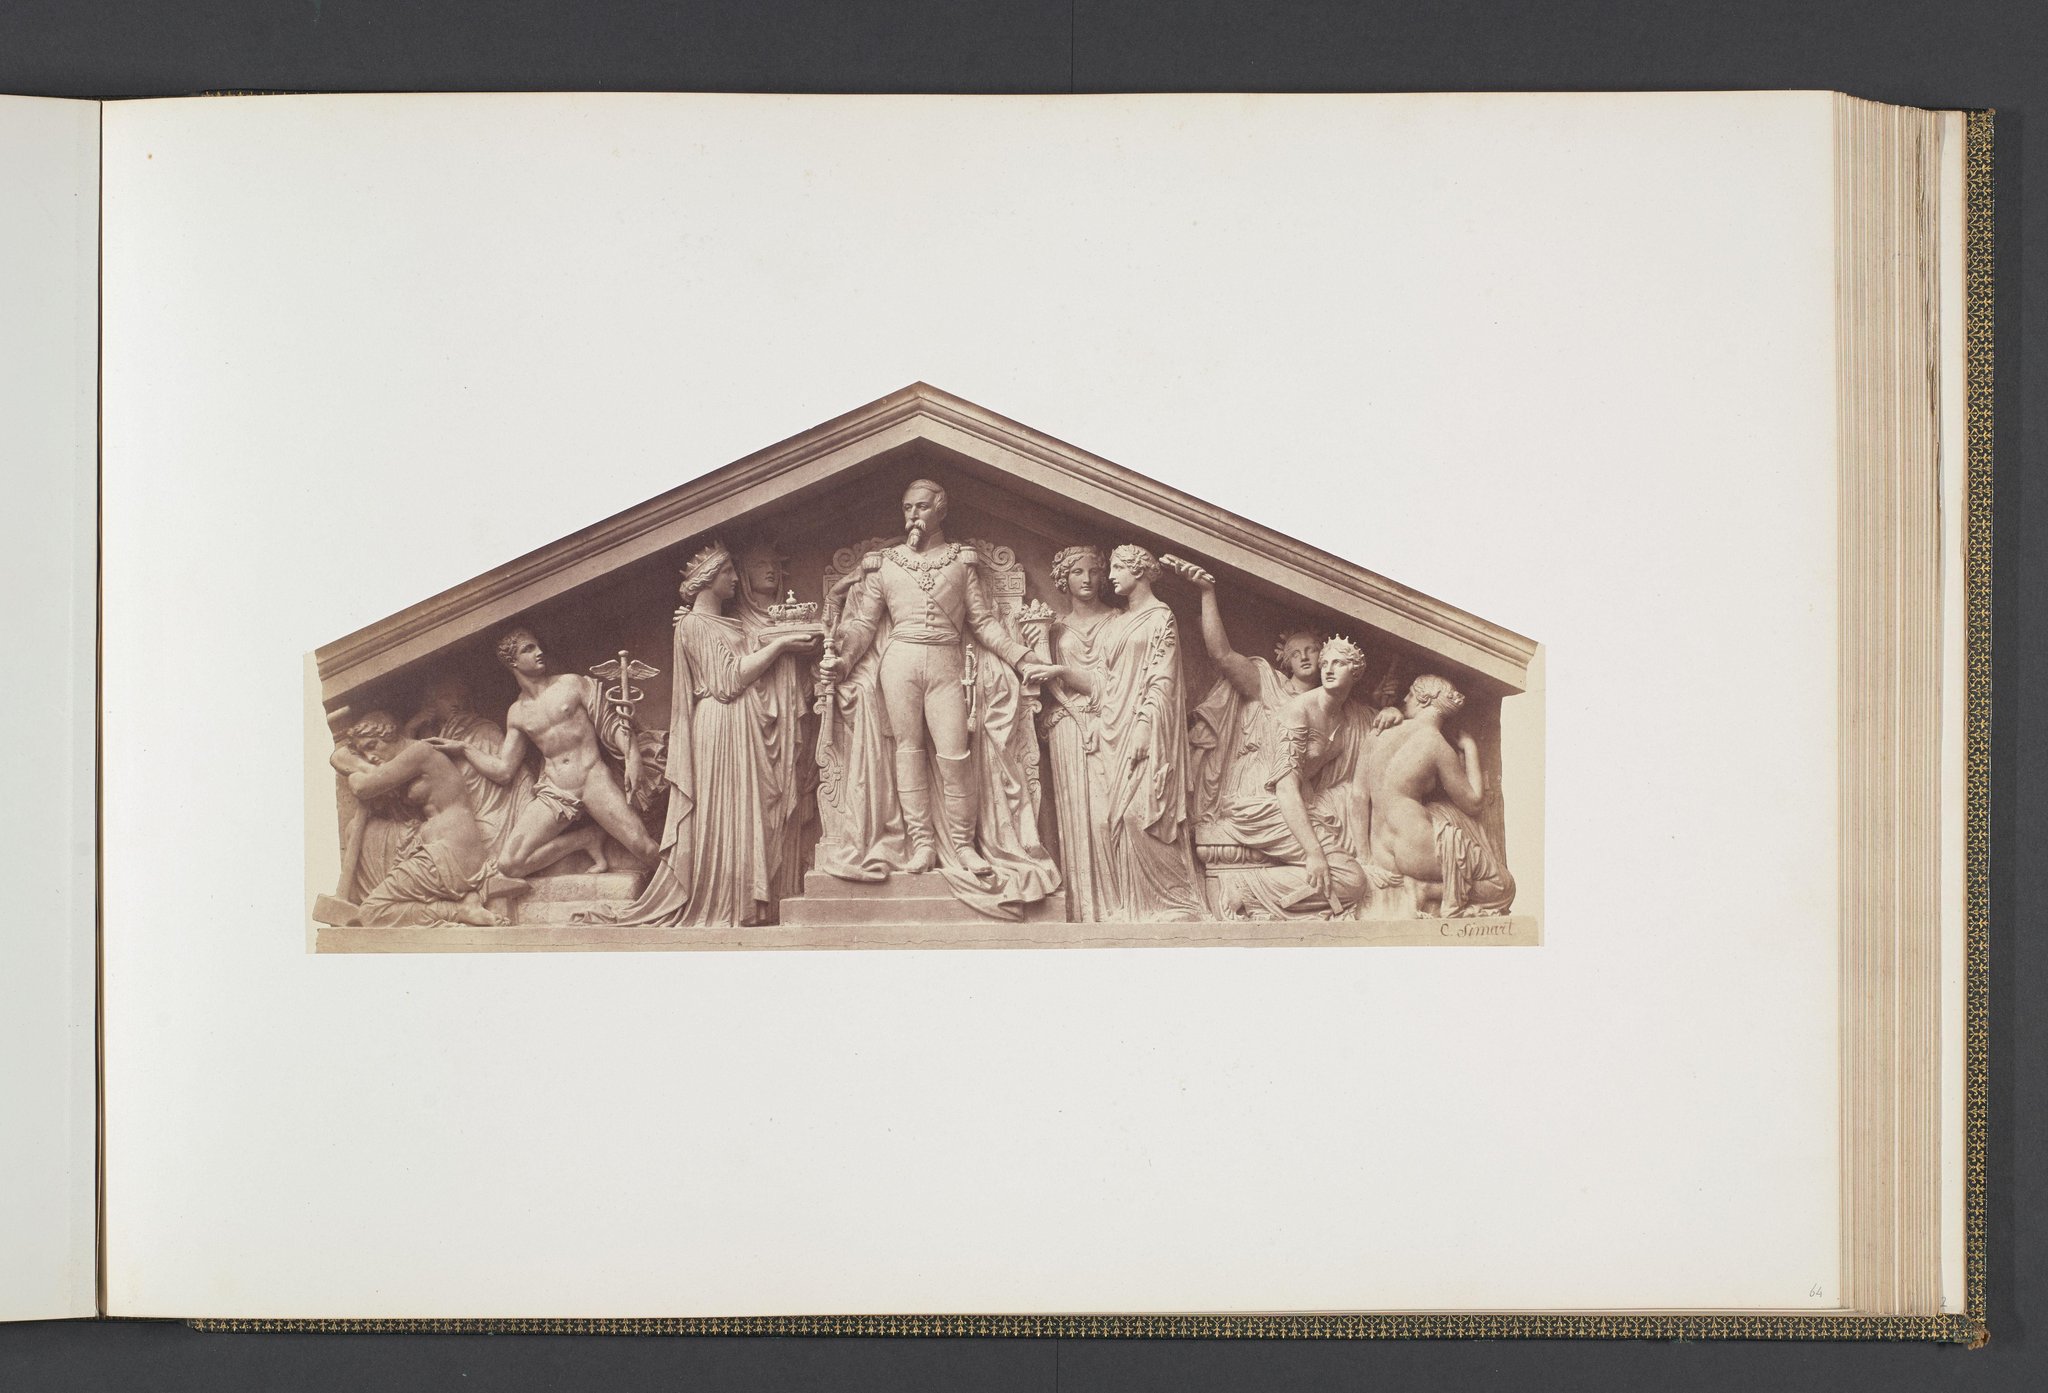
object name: album leaf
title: Gipsmodel voor het fronton van het Pavillon Denon door Pierre Charles Simart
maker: édouard denis baldus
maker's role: fotograaf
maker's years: 1813-1889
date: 1855-1857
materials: paper, photographic support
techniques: salted paper print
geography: paris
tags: paris, london, napoleon iii (keizer der fransen), other architectural details (with name), permanent exhibition, museum, tuileries palace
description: Onderdeel van Réunion des Tuileries au Louvre 1852-1857, album 2.